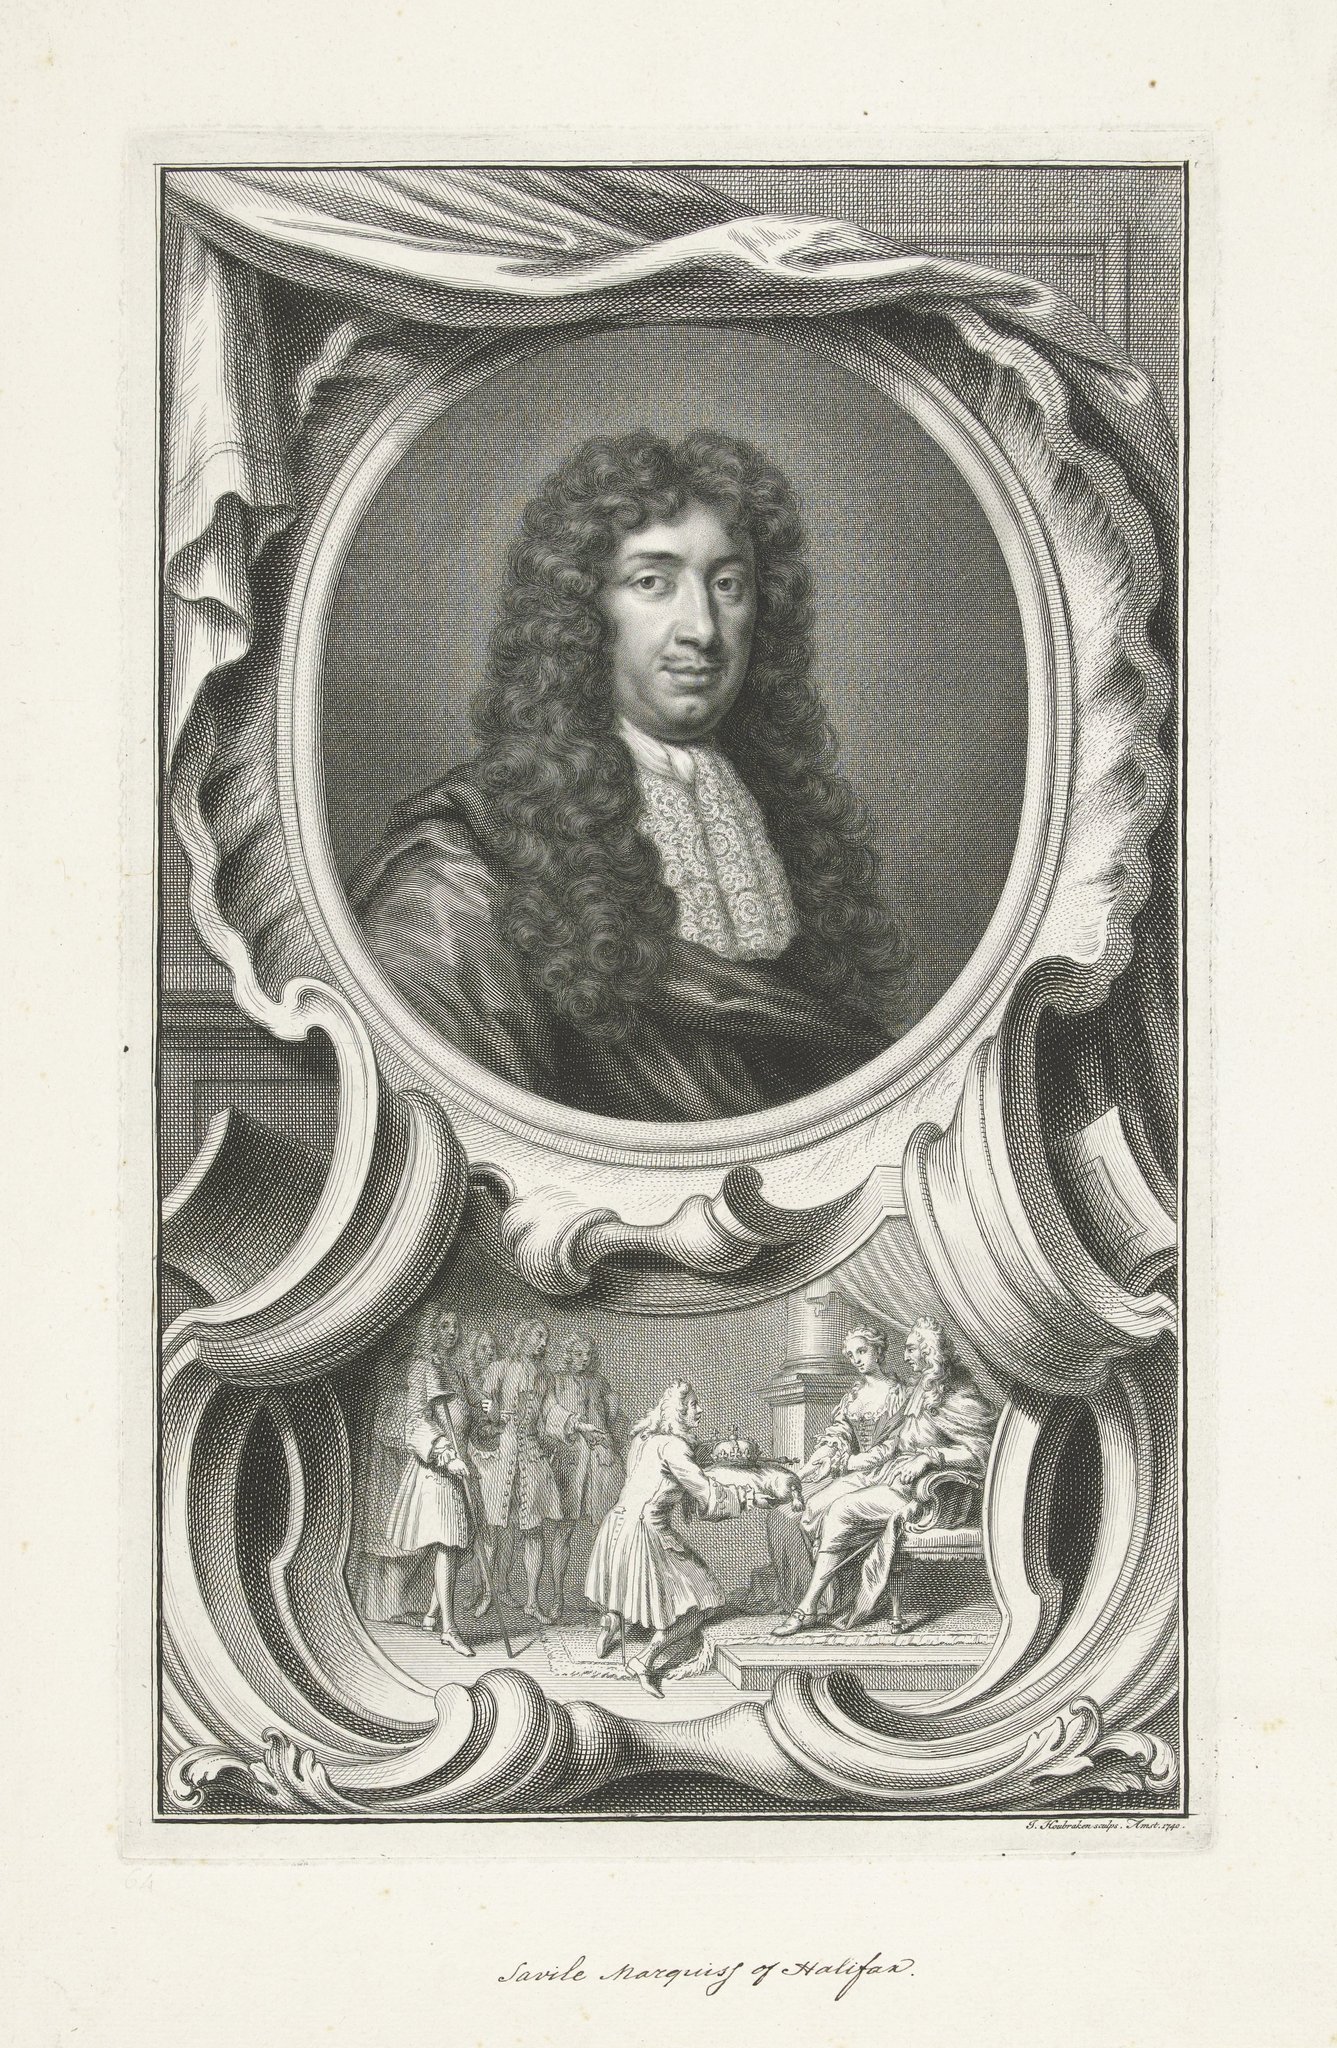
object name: print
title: Portret van sir George Savile, eerste markies van Halifax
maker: jacob houbraken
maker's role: draughtsman, print maker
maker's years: 1698-1780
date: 1740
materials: paper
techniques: engraving, etching, pen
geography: amsterdam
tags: william iii (prince of orange and king of england, scotland, and ireland), london, maria ii stuart (koningin van engeland, schotland en ierland)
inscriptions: collector's mark: Lugt 240, name: ‘Savile Marquiss of Halifax’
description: Portret van sir George Savile, eerste markies van Halifax. Onder het portret een cartouche waarin Savile de Engelse kroon aanbiedt aan Willem III en zijn echtgenote Mary II Stuart, op 13 februari 1689.